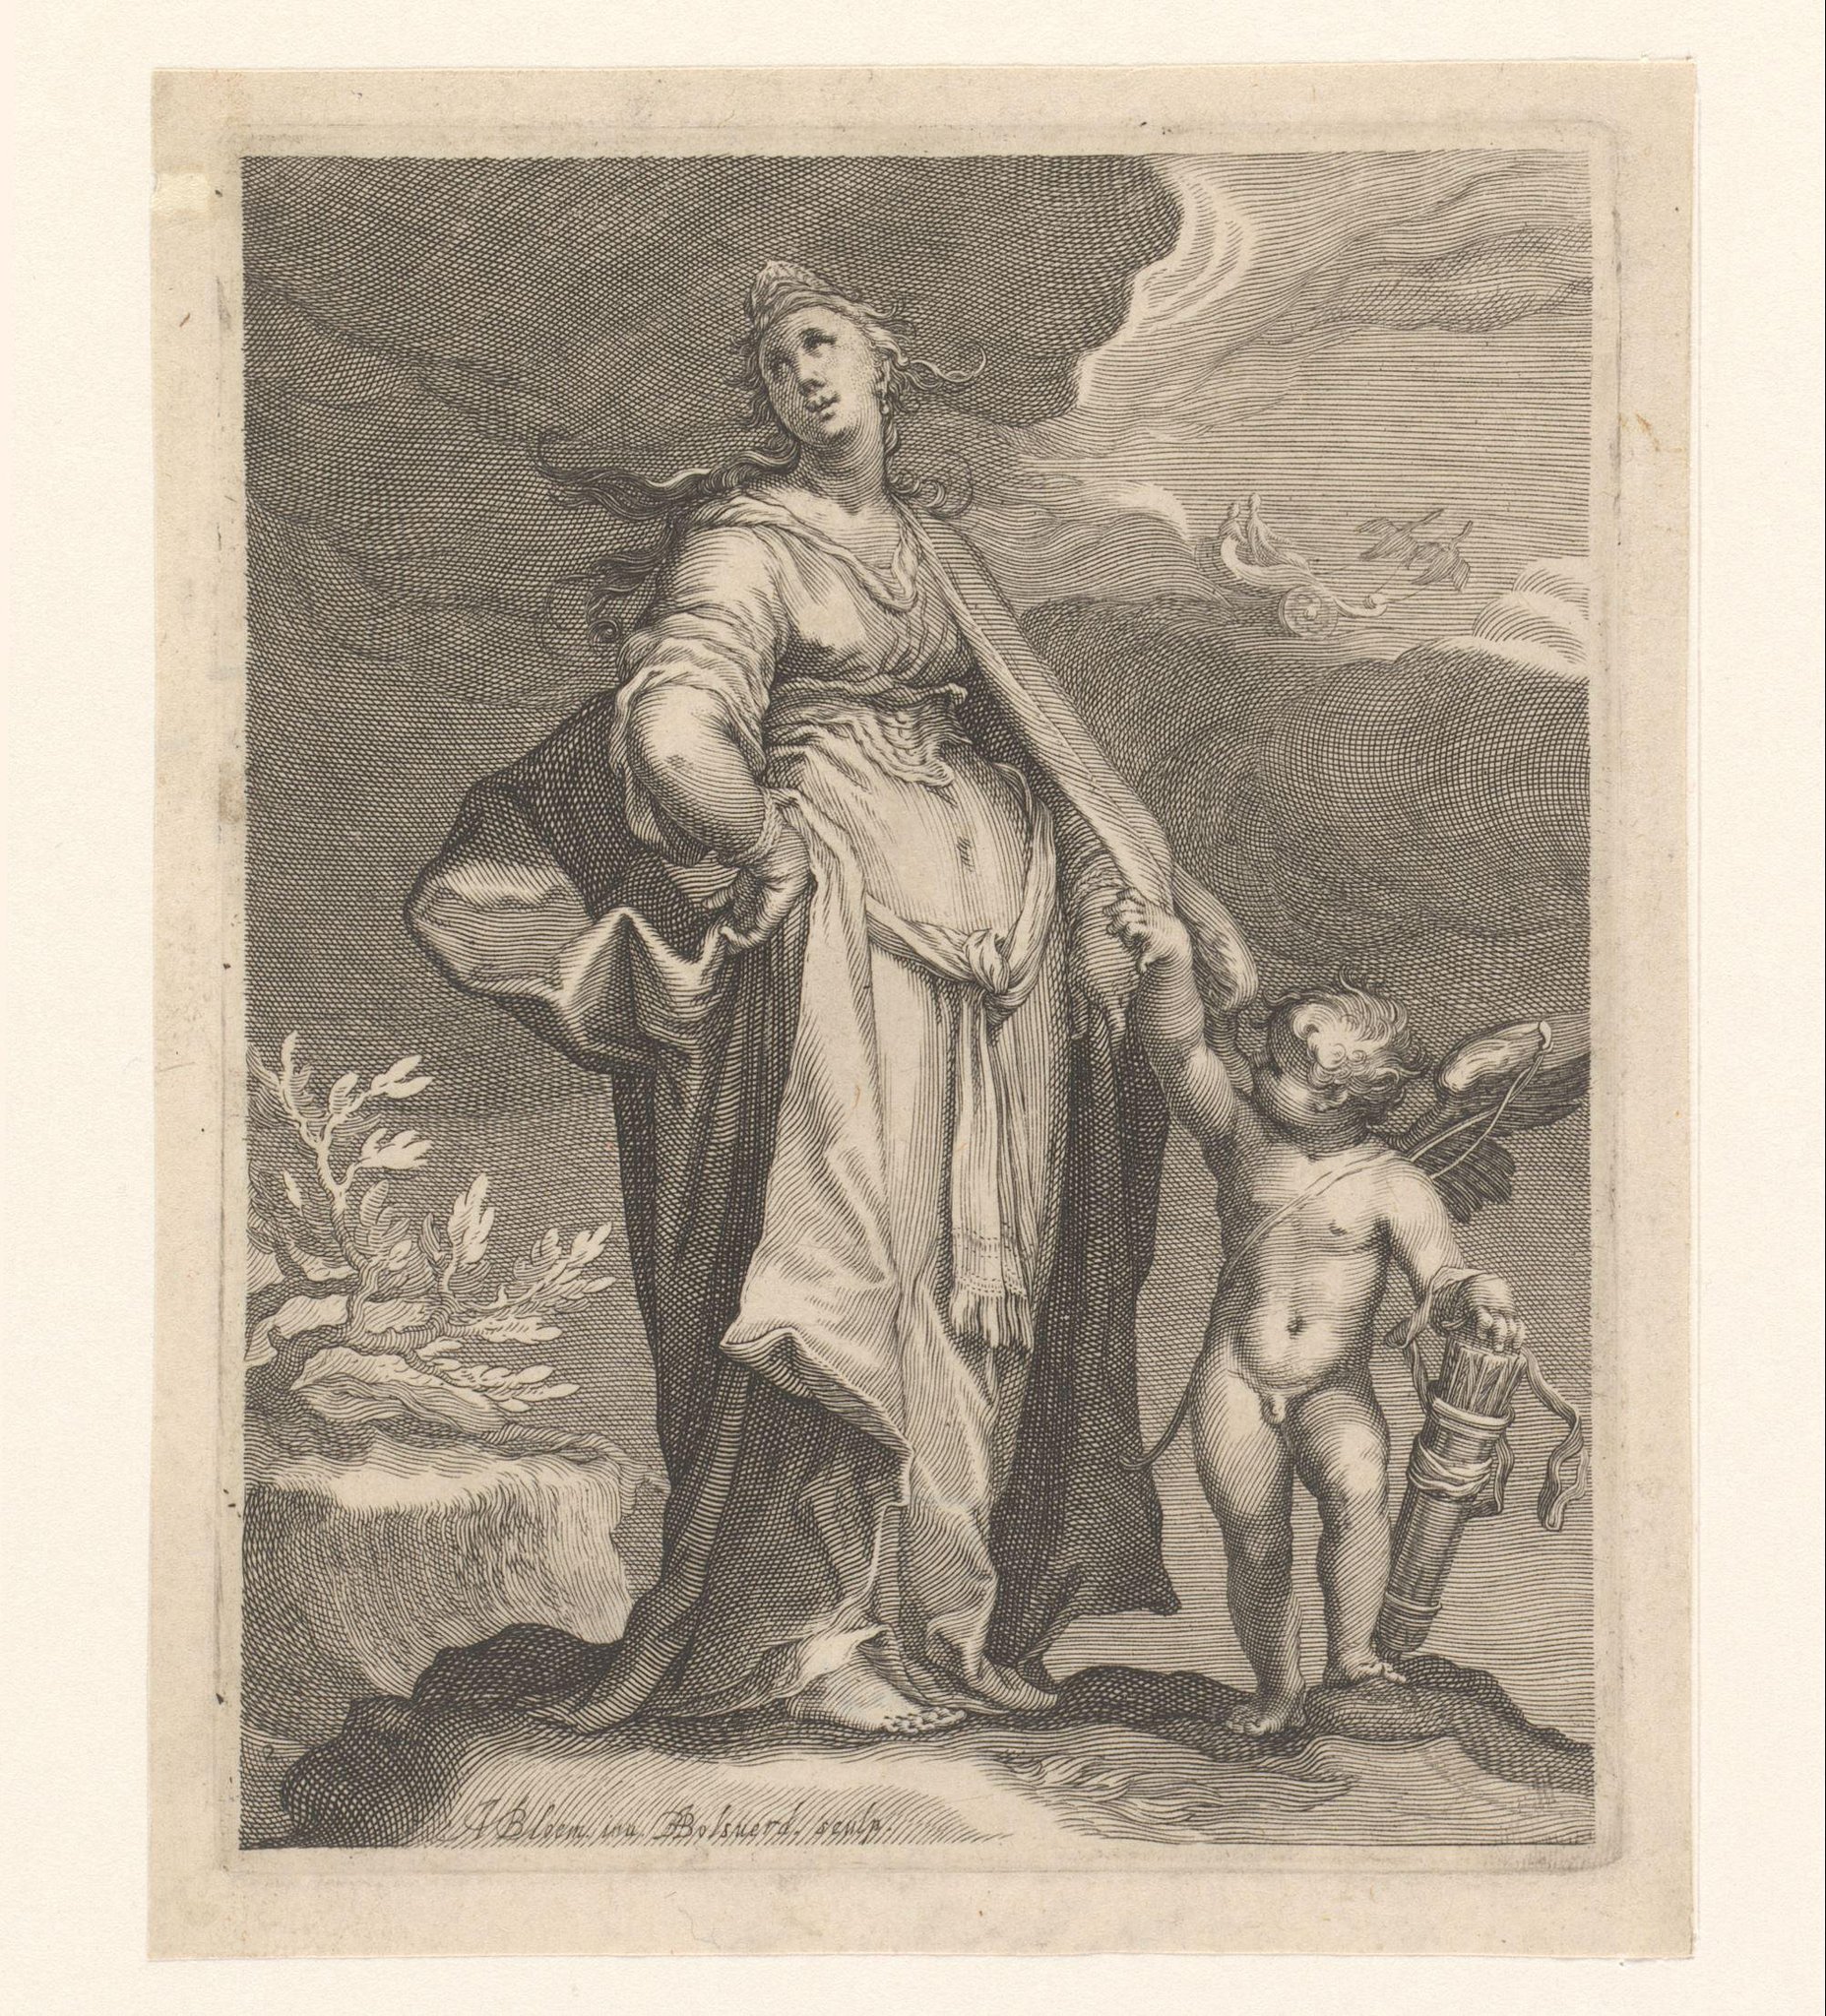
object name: print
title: Venus en Cupido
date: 1612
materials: paper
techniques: engraving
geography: low countries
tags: venus and cupid (cupid not being mere attribute)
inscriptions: inscription: ‘18/ 2 14’, collector's mark: Lugt 228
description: Rechts in de wolken Venus in haar door zwanen getrokken wagen.